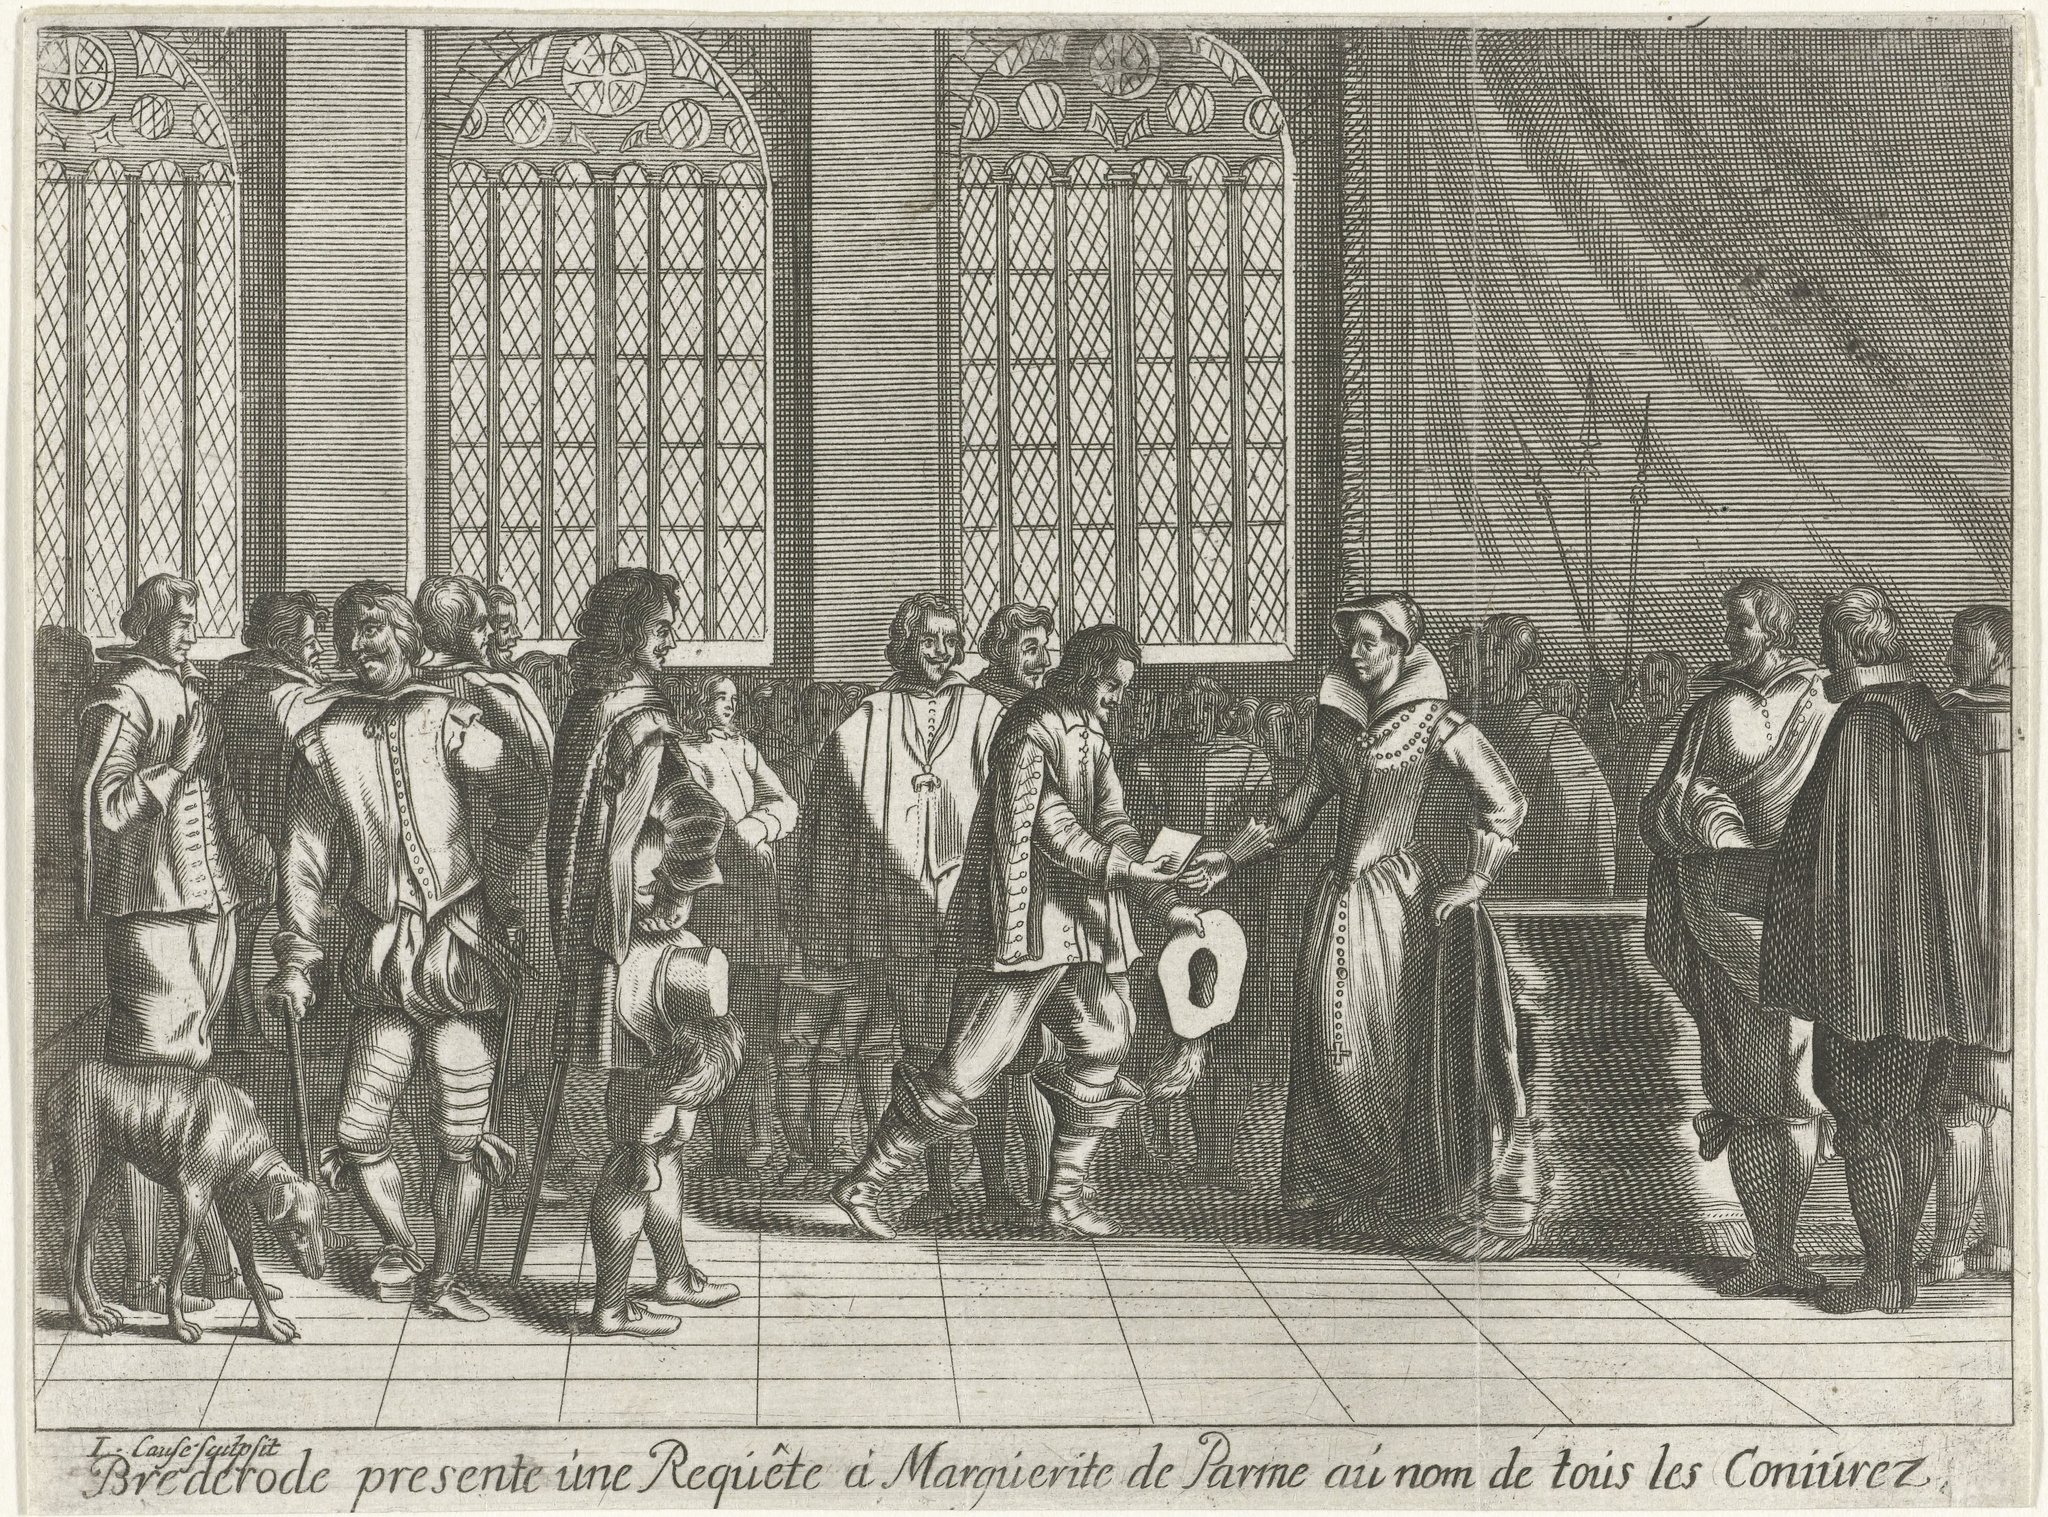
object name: history print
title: Brederode presente une Requête à Marguerite de Parme au nom de tous les Coniurez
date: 1690-1750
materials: paper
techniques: engraving, etching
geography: low countries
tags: hendrik van brederode (heer van vianen), oudenaarde, ortona, landvoogd, landvoogdes der nederlanden margaretha van parma, paleis op de koudenberg, smeekschrift der edelen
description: Het aanbieden van het Smeekschrift door het verbond der edelen aan de landvoogdes, de hertogin van Parma, in het paleis te Brussel 5 april 1566. Hendrik van Brederode overhandigt haar het verzoekschrift.